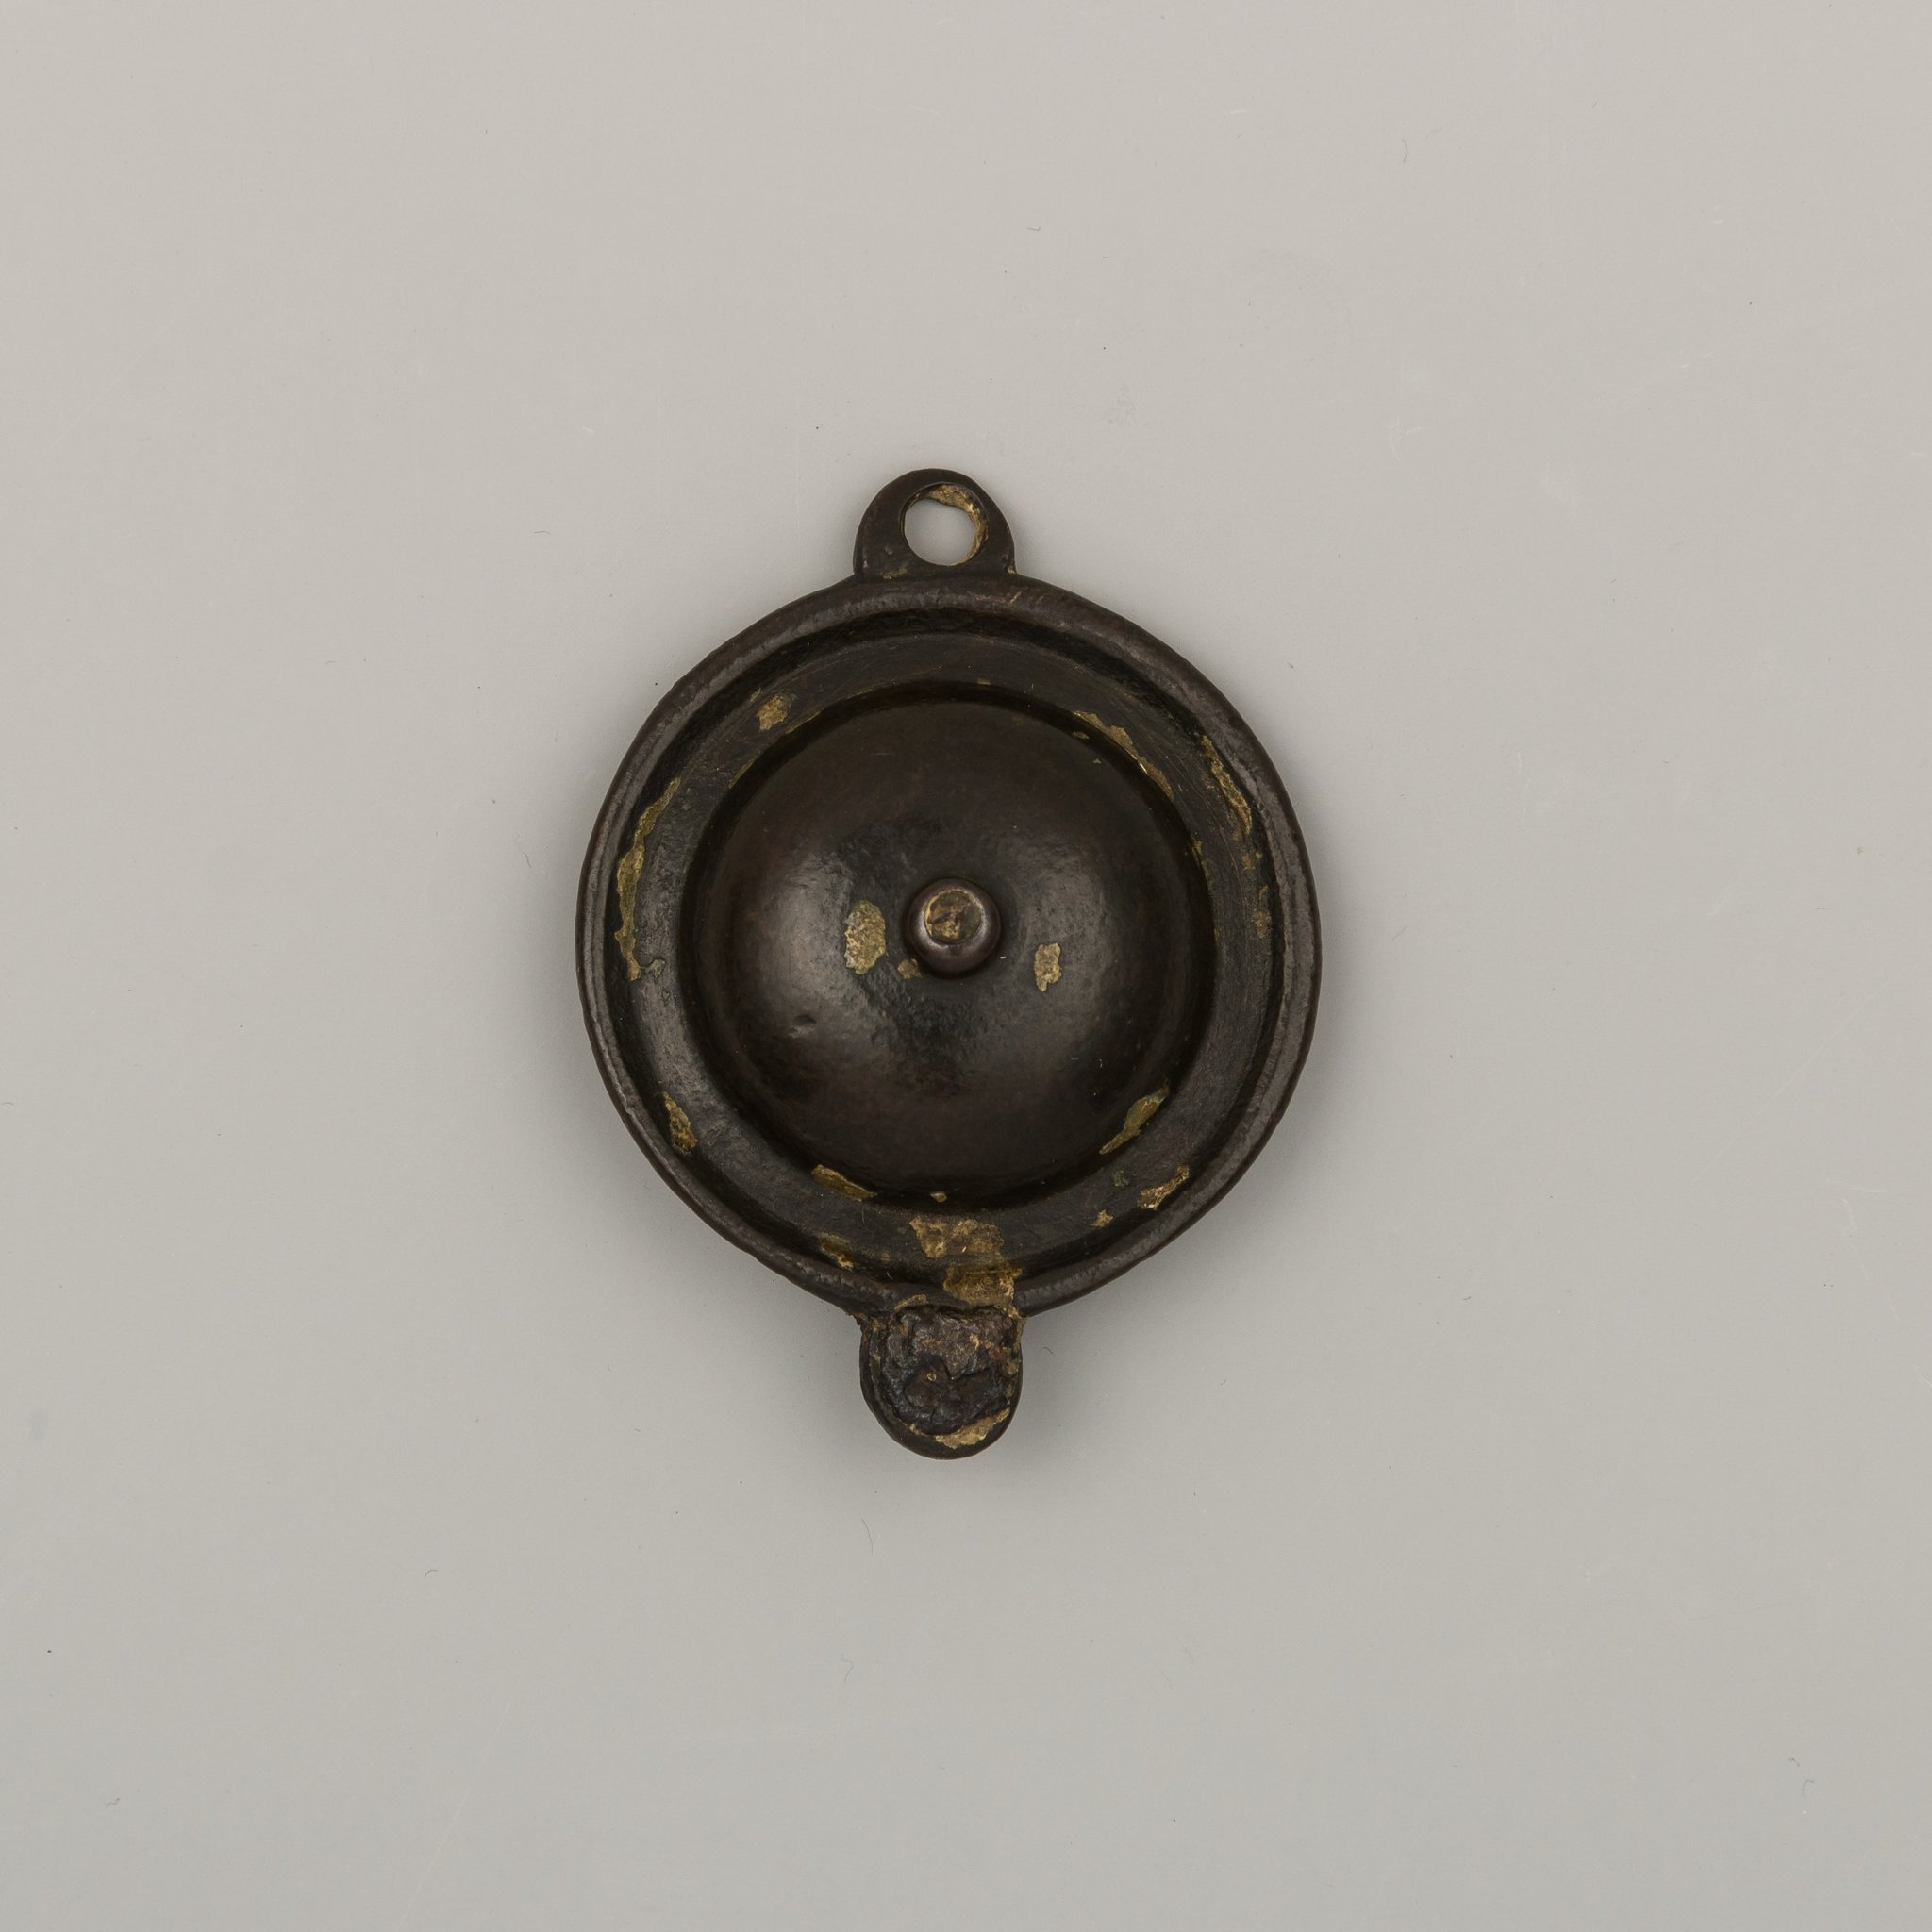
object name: bit bos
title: Bit Boss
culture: french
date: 1667-1733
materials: copper alloy, iron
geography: france